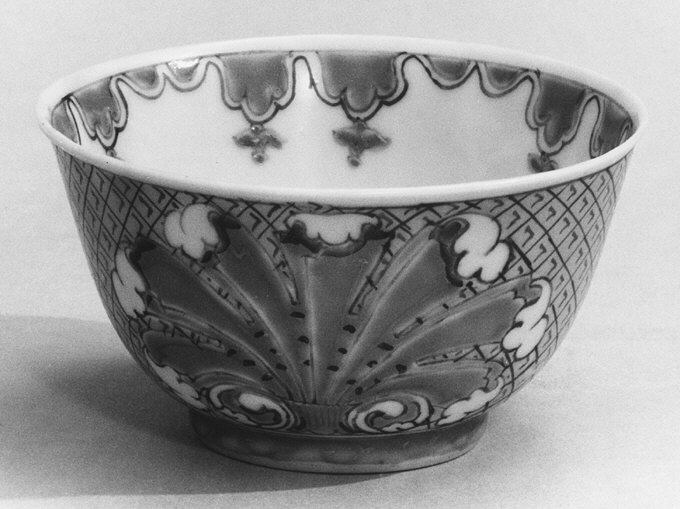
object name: cup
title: Cup (part of a service)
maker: cornelis pronk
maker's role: artist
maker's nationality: dutch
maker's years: 1691-1759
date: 1740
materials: hard paste porcelain